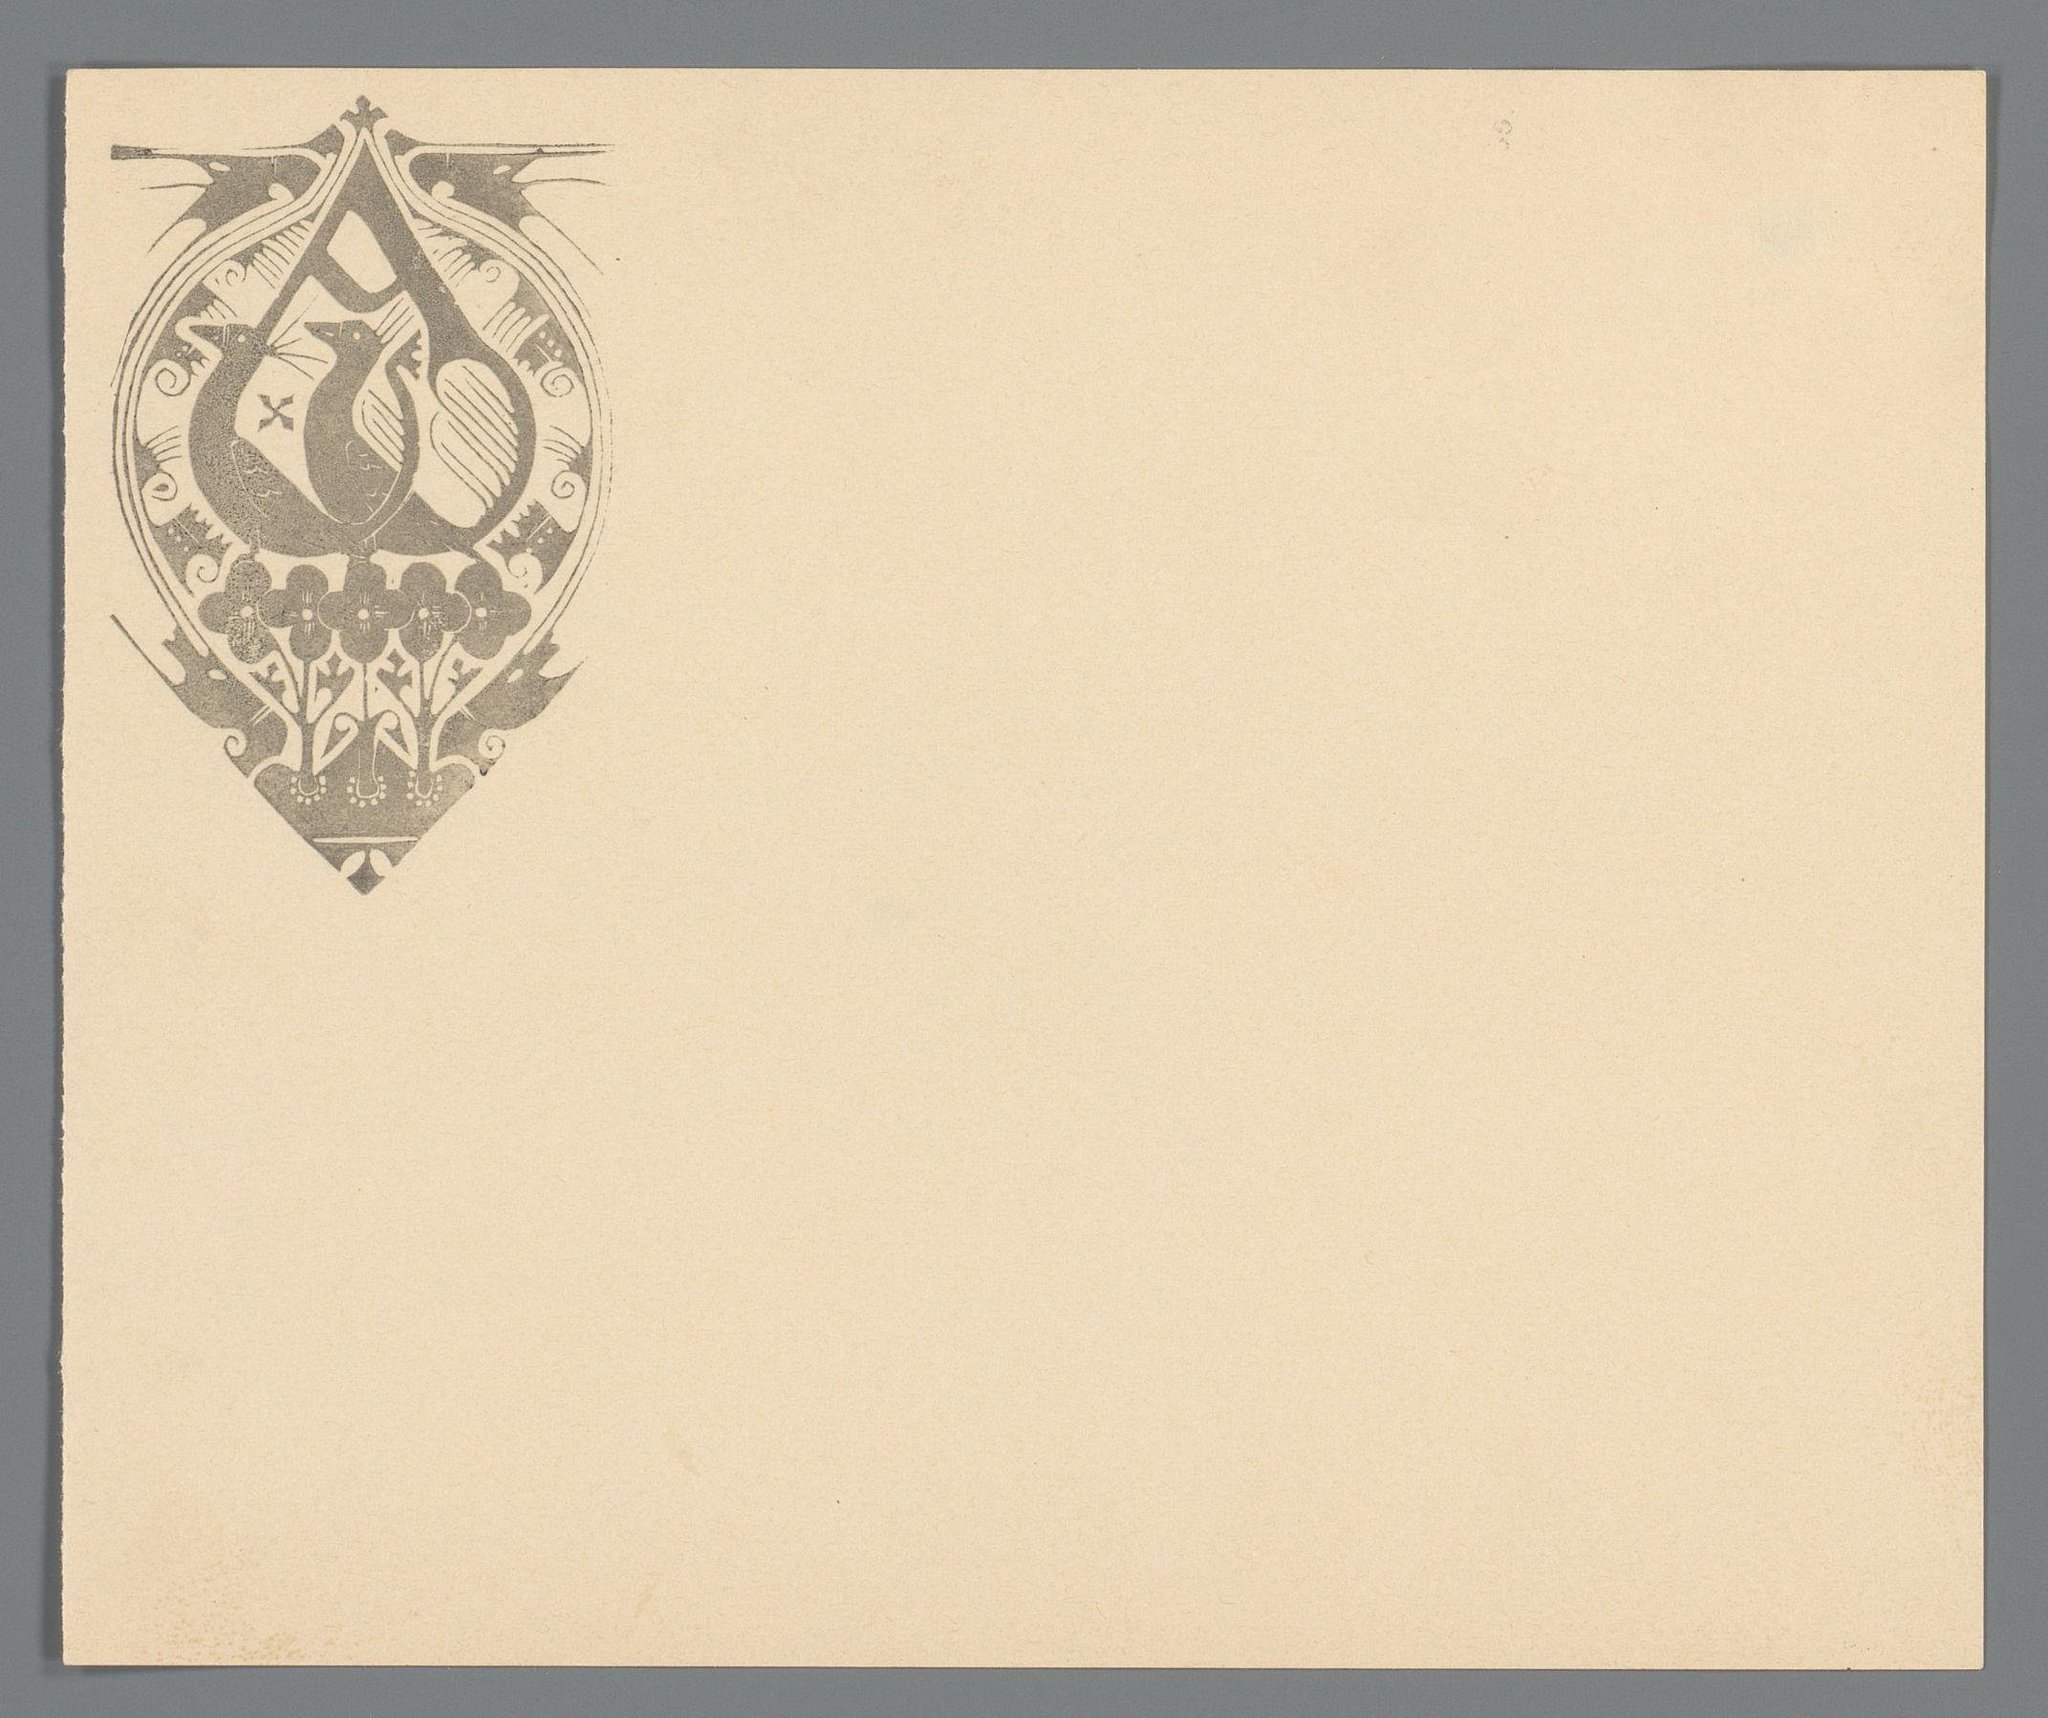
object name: print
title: Briefpapier met als briefhoofd een vignet met de Griekse letters Alpha en Omega gevormd door pauwen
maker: mathieu lauweriks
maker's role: designer, draughtsman, print maker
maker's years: 1864-1932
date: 1890-1930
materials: paper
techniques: woodcut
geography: amsterdam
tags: greek script, ornament derived from animal forms, miscellaneous religions, cults and doctrines: theosophy, ornamental birds: peacock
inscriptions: collector's mark: Lugt 2228